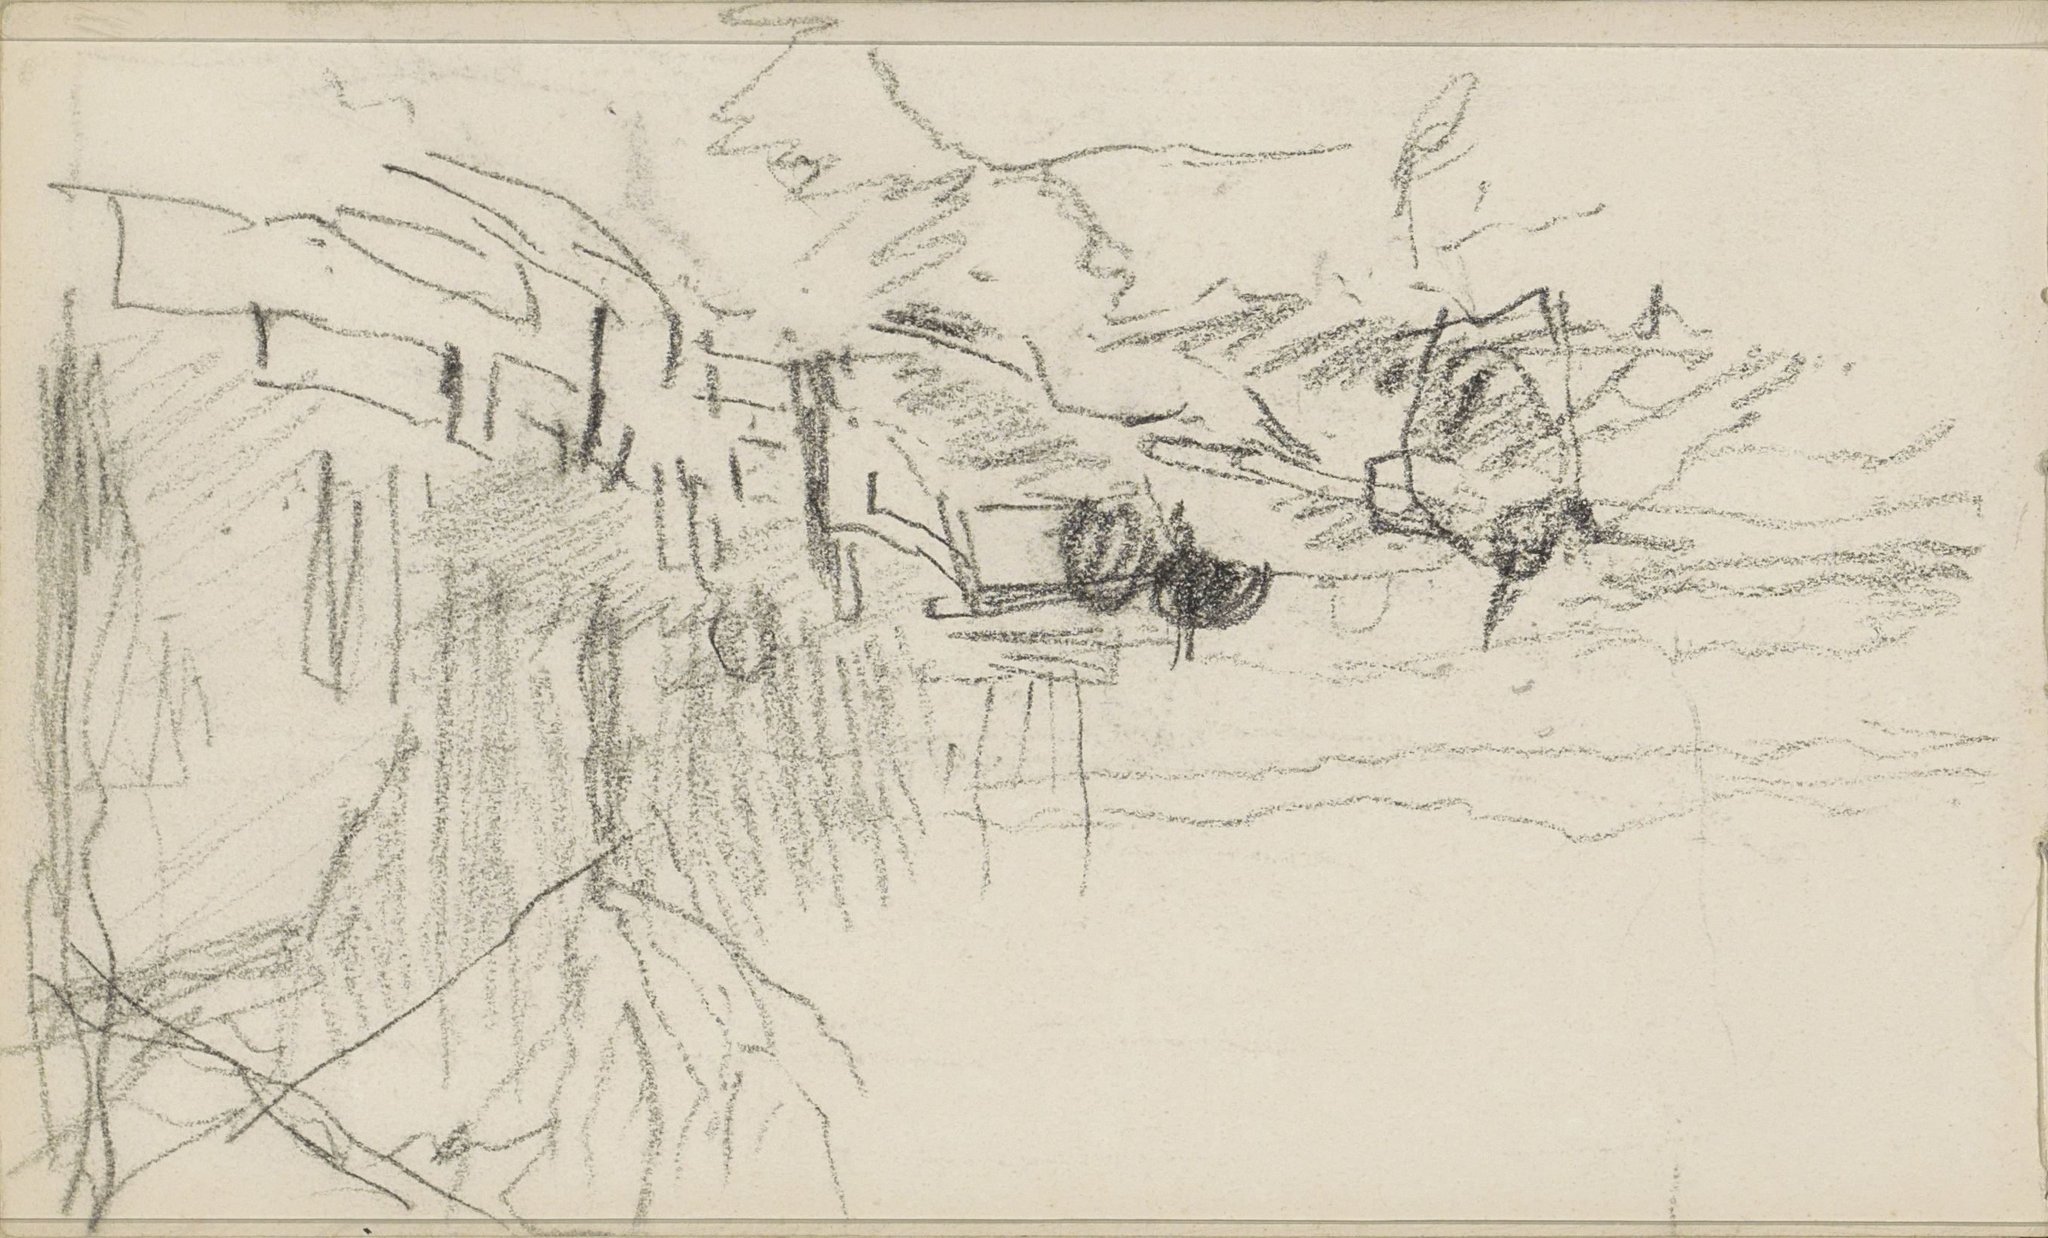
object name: sketchbook leaf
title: Weiland omgrensd door een hek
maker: anton mauve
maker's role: draughtsman, painter, print maker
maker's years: 1838-1888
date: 1848-1888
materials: chalk, paper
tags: meadow, pasture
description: Blad 26 verso uit een schetsboek met 33 bladen.